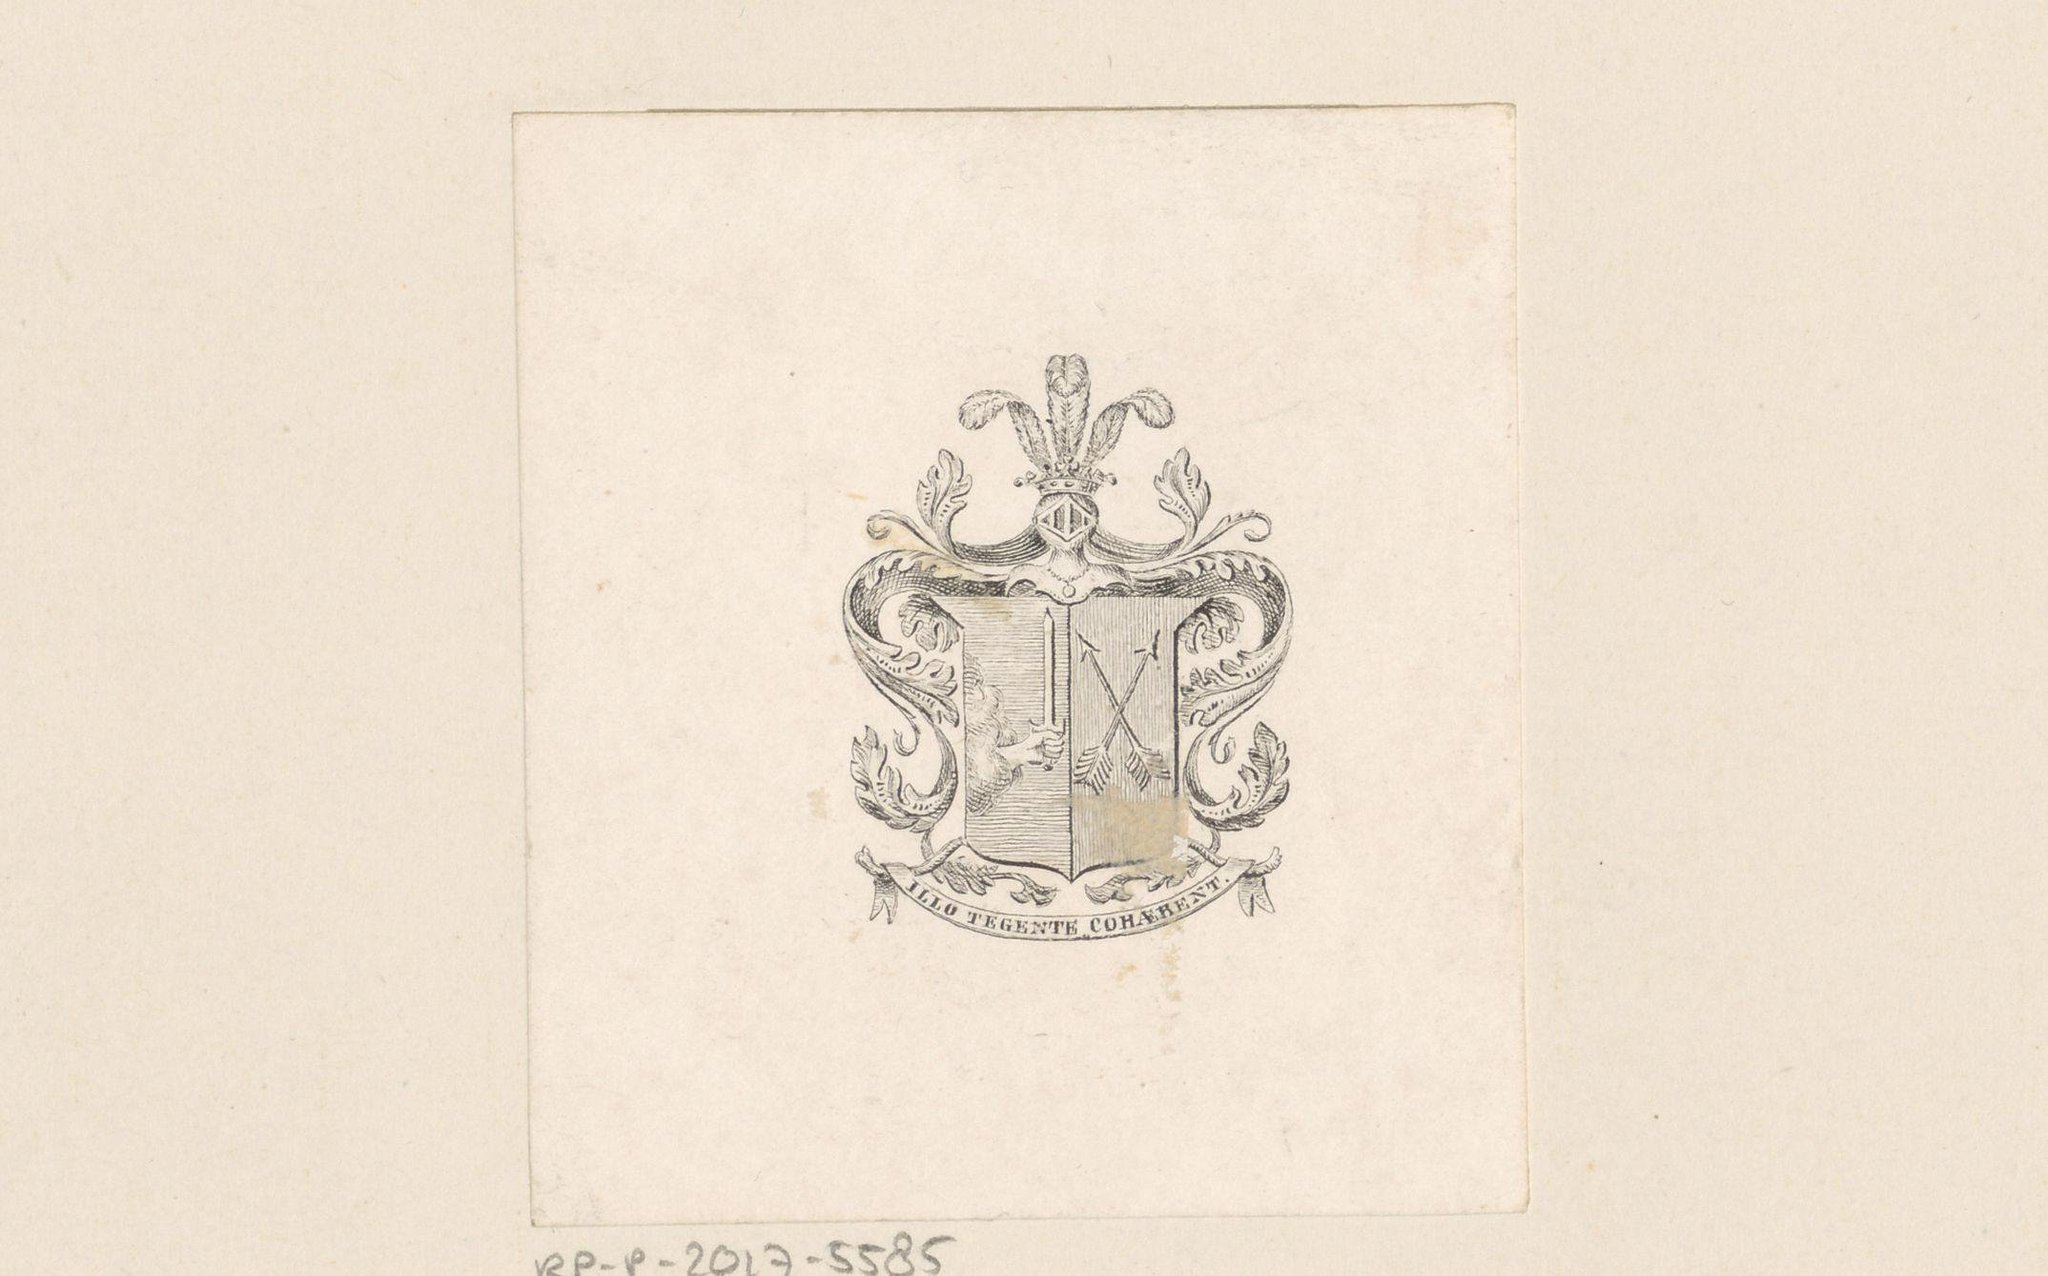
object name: bookplate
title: Illo tegente cohaerent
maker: Anonymous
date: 1850-1924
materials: paper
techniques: etching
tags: archer's weapons: arrow, hacking and thrusting weapons: sword, armorial bearing, heraldry